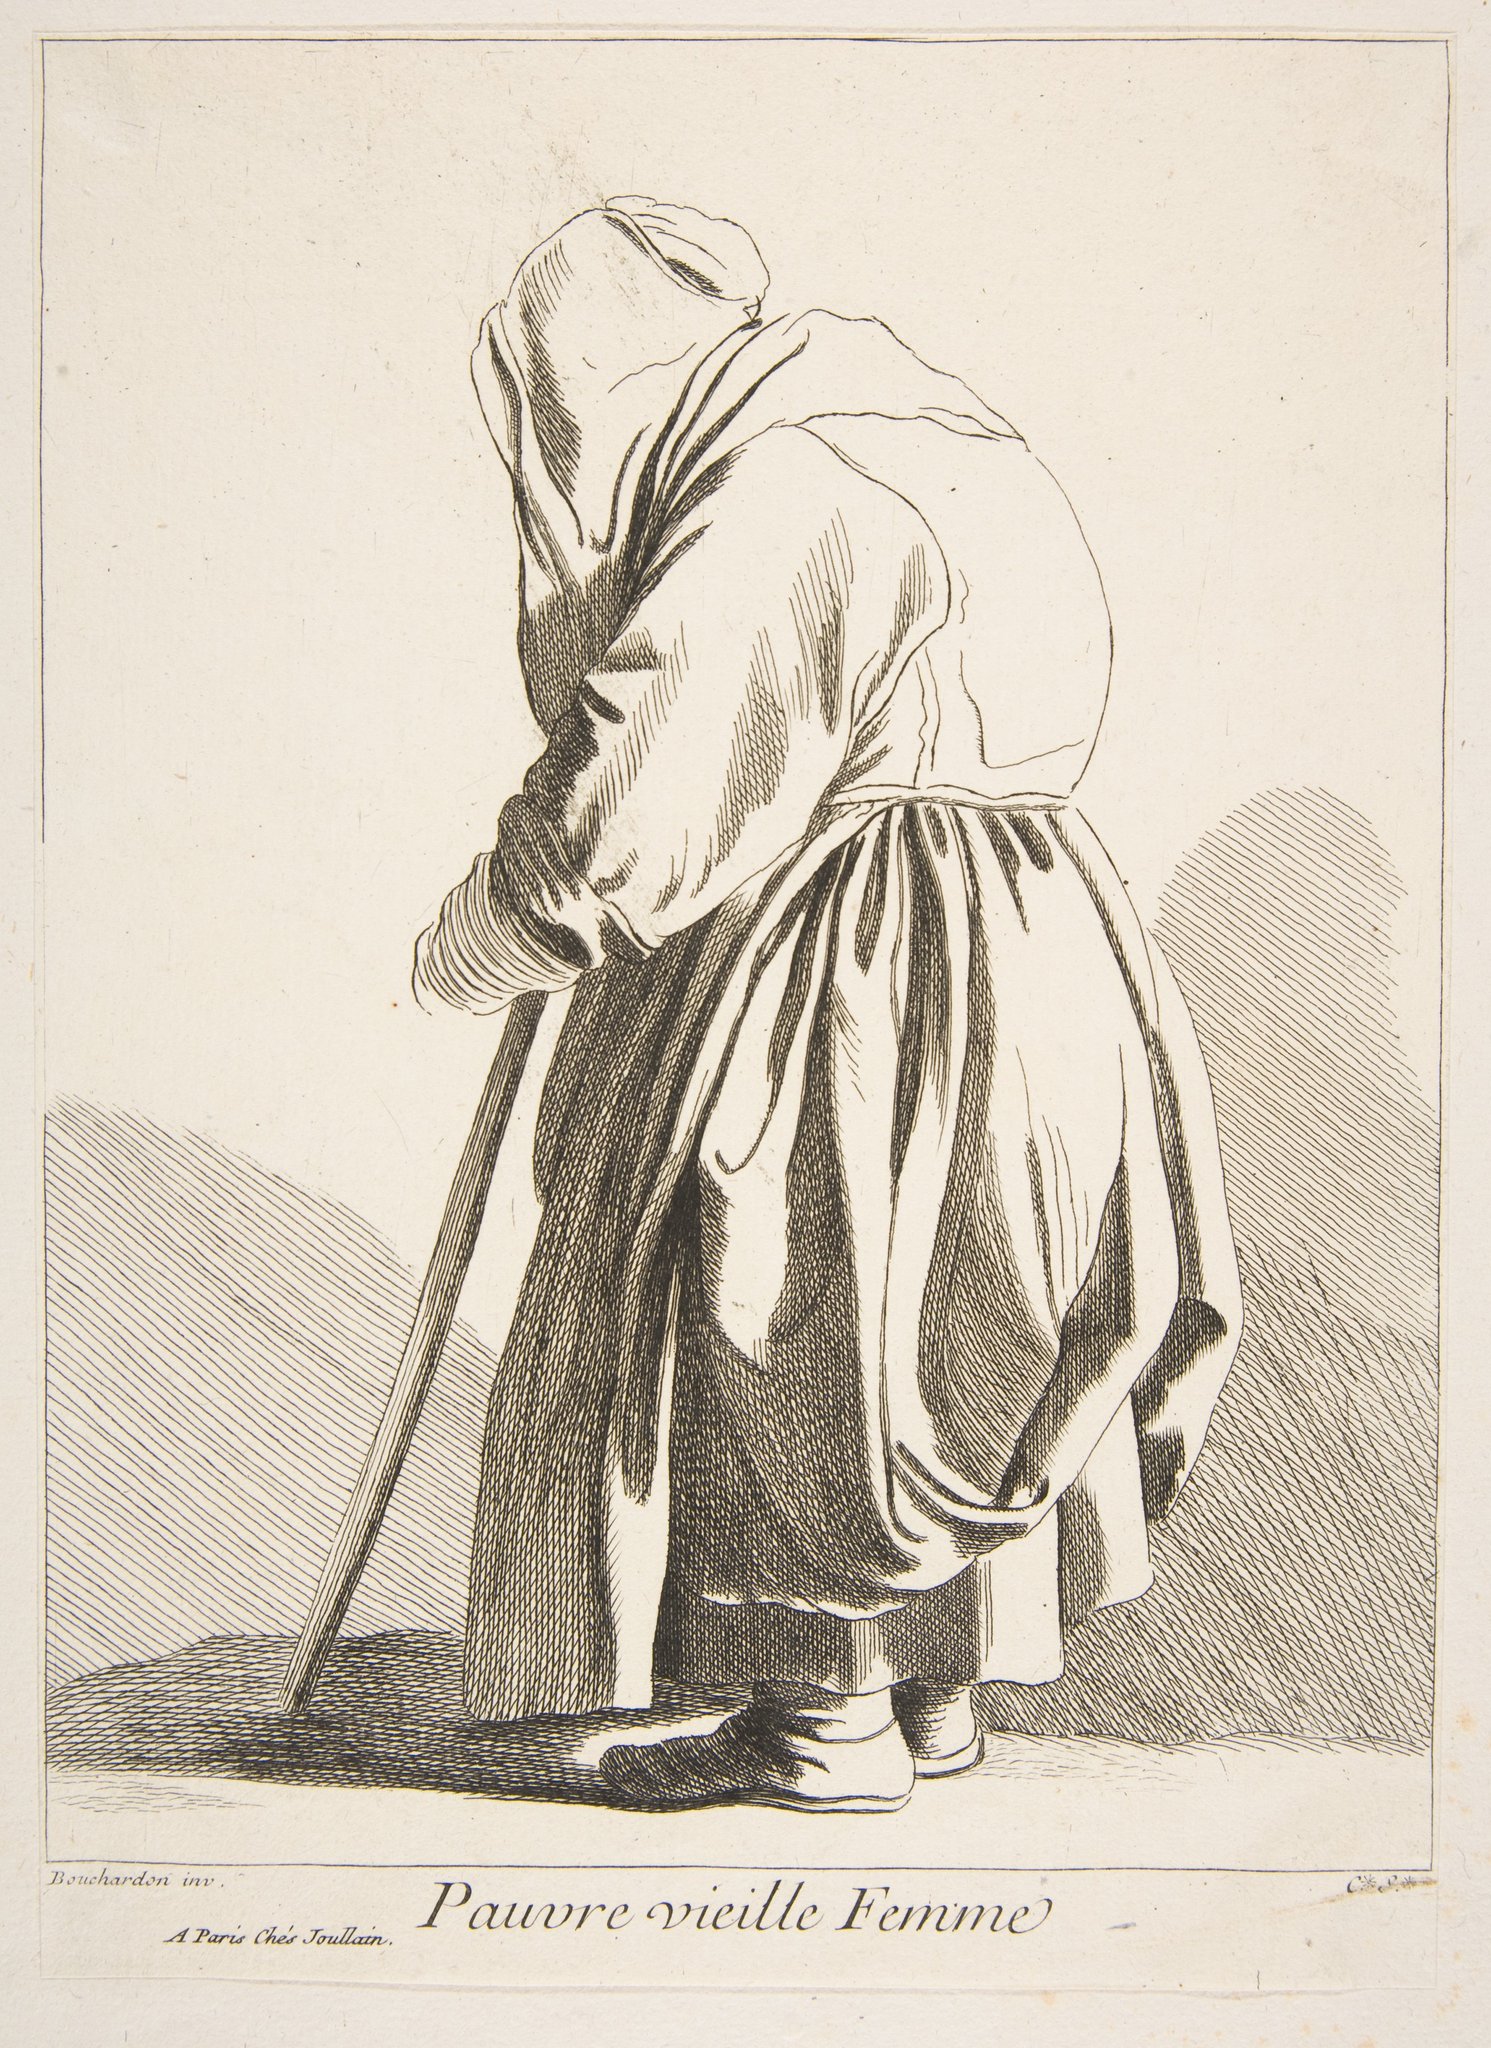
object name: print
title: A Poor Old Woman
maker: anne claude philippe de tubières, comte de caylus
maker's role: artist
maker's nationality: french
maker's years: 1692-1765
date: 1742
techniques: engraving, etching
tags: women